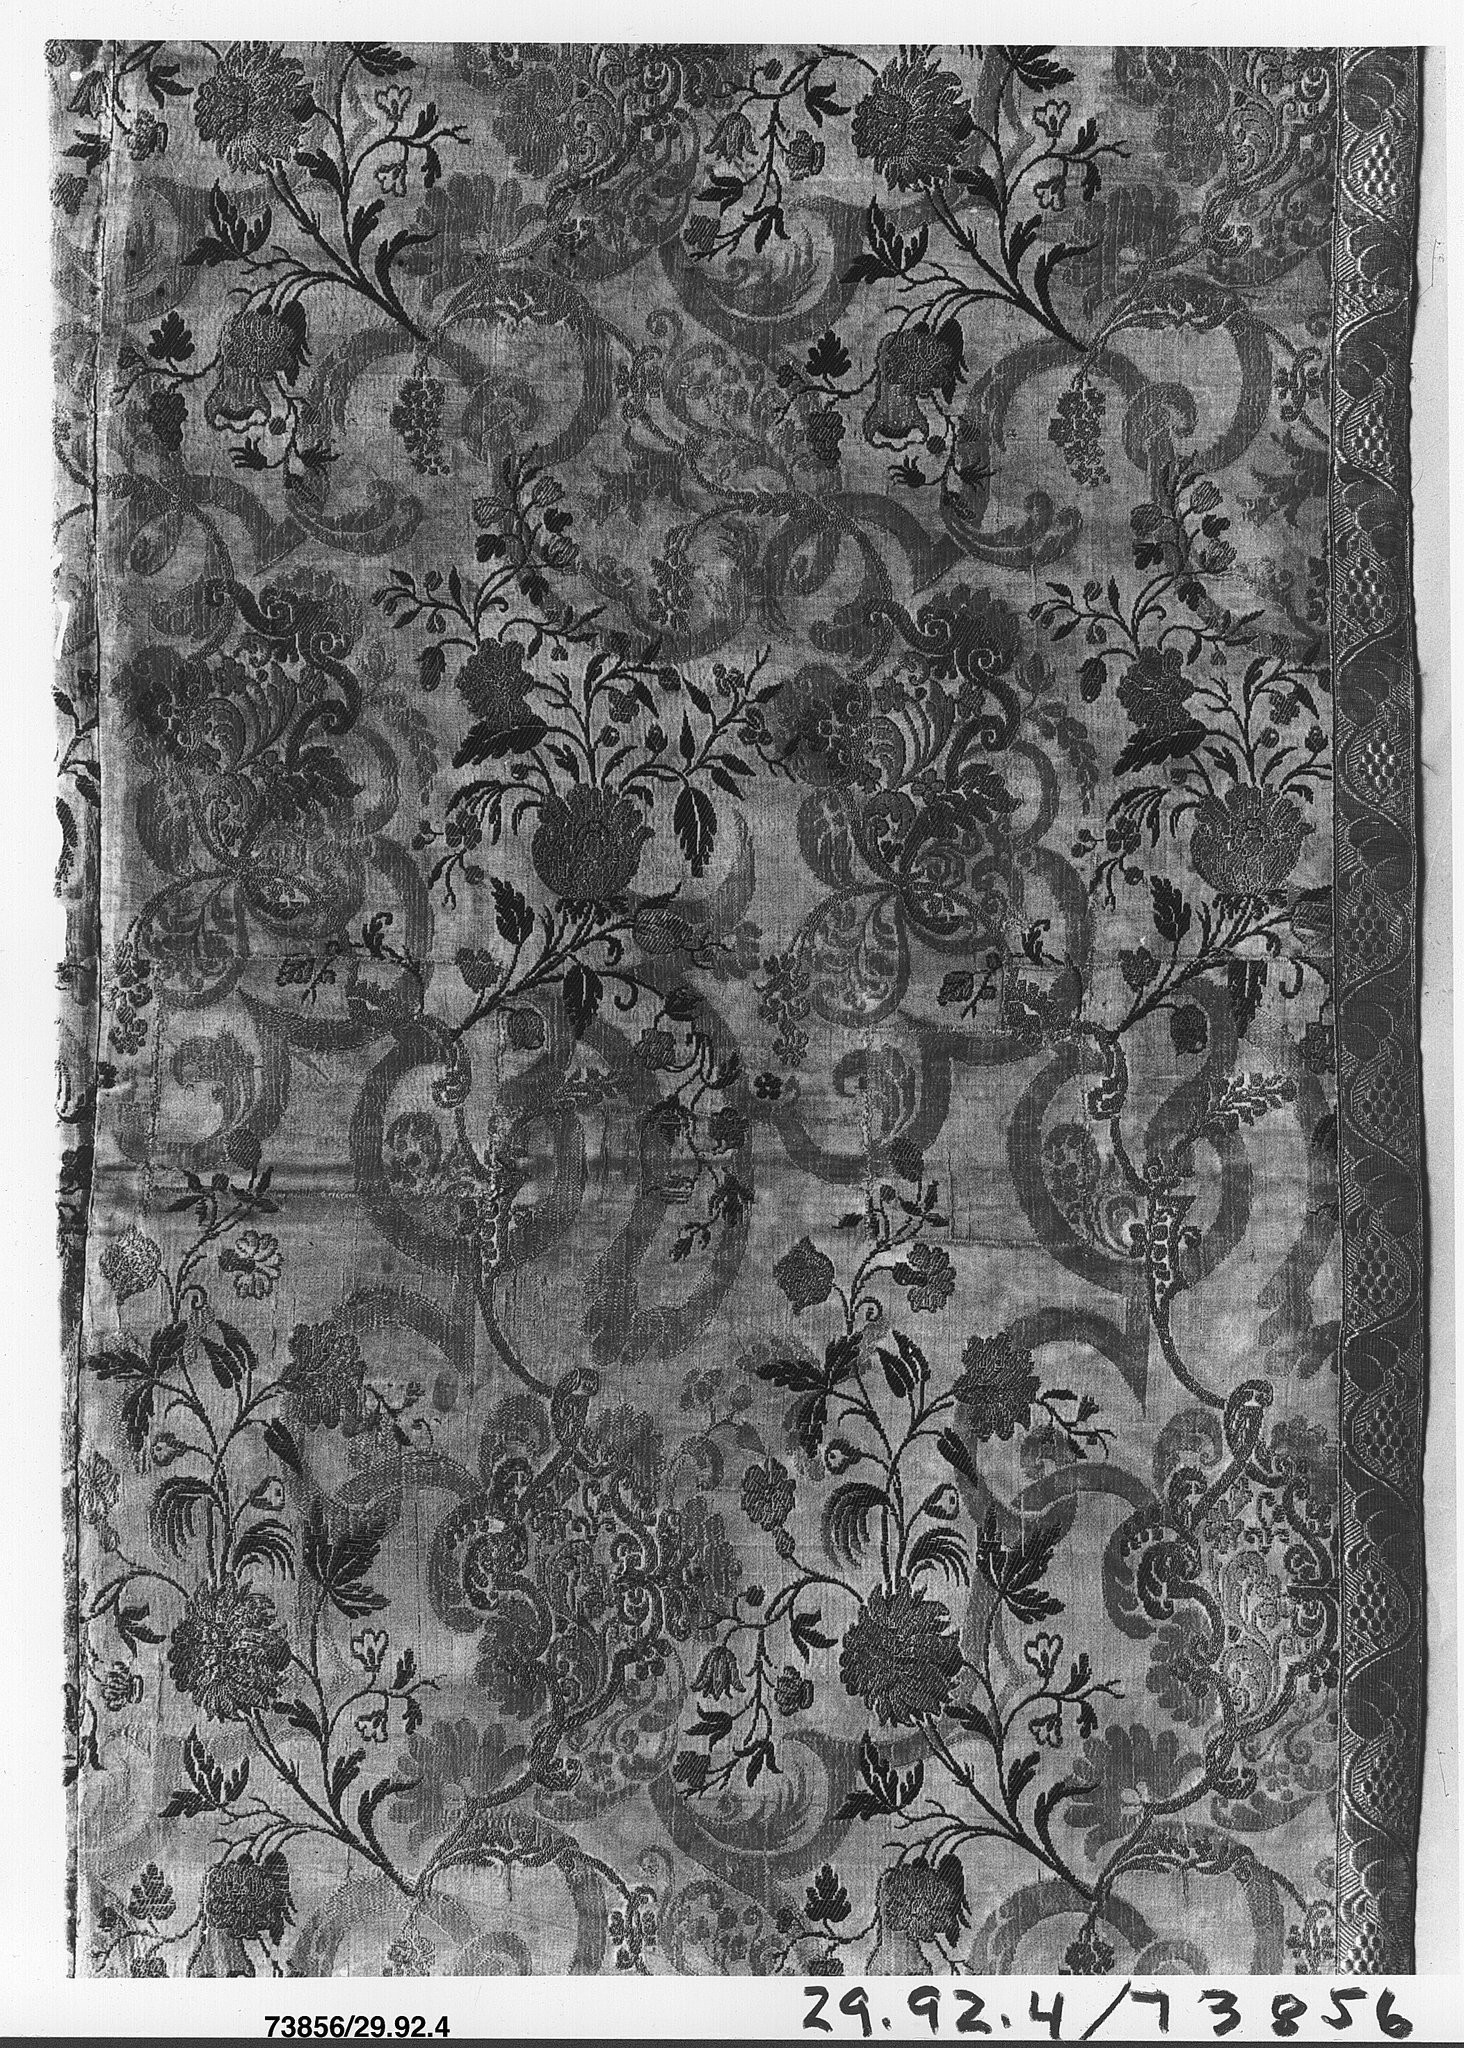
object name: piece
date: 1705-1710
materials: metal thread, silk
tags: flowers,leaves